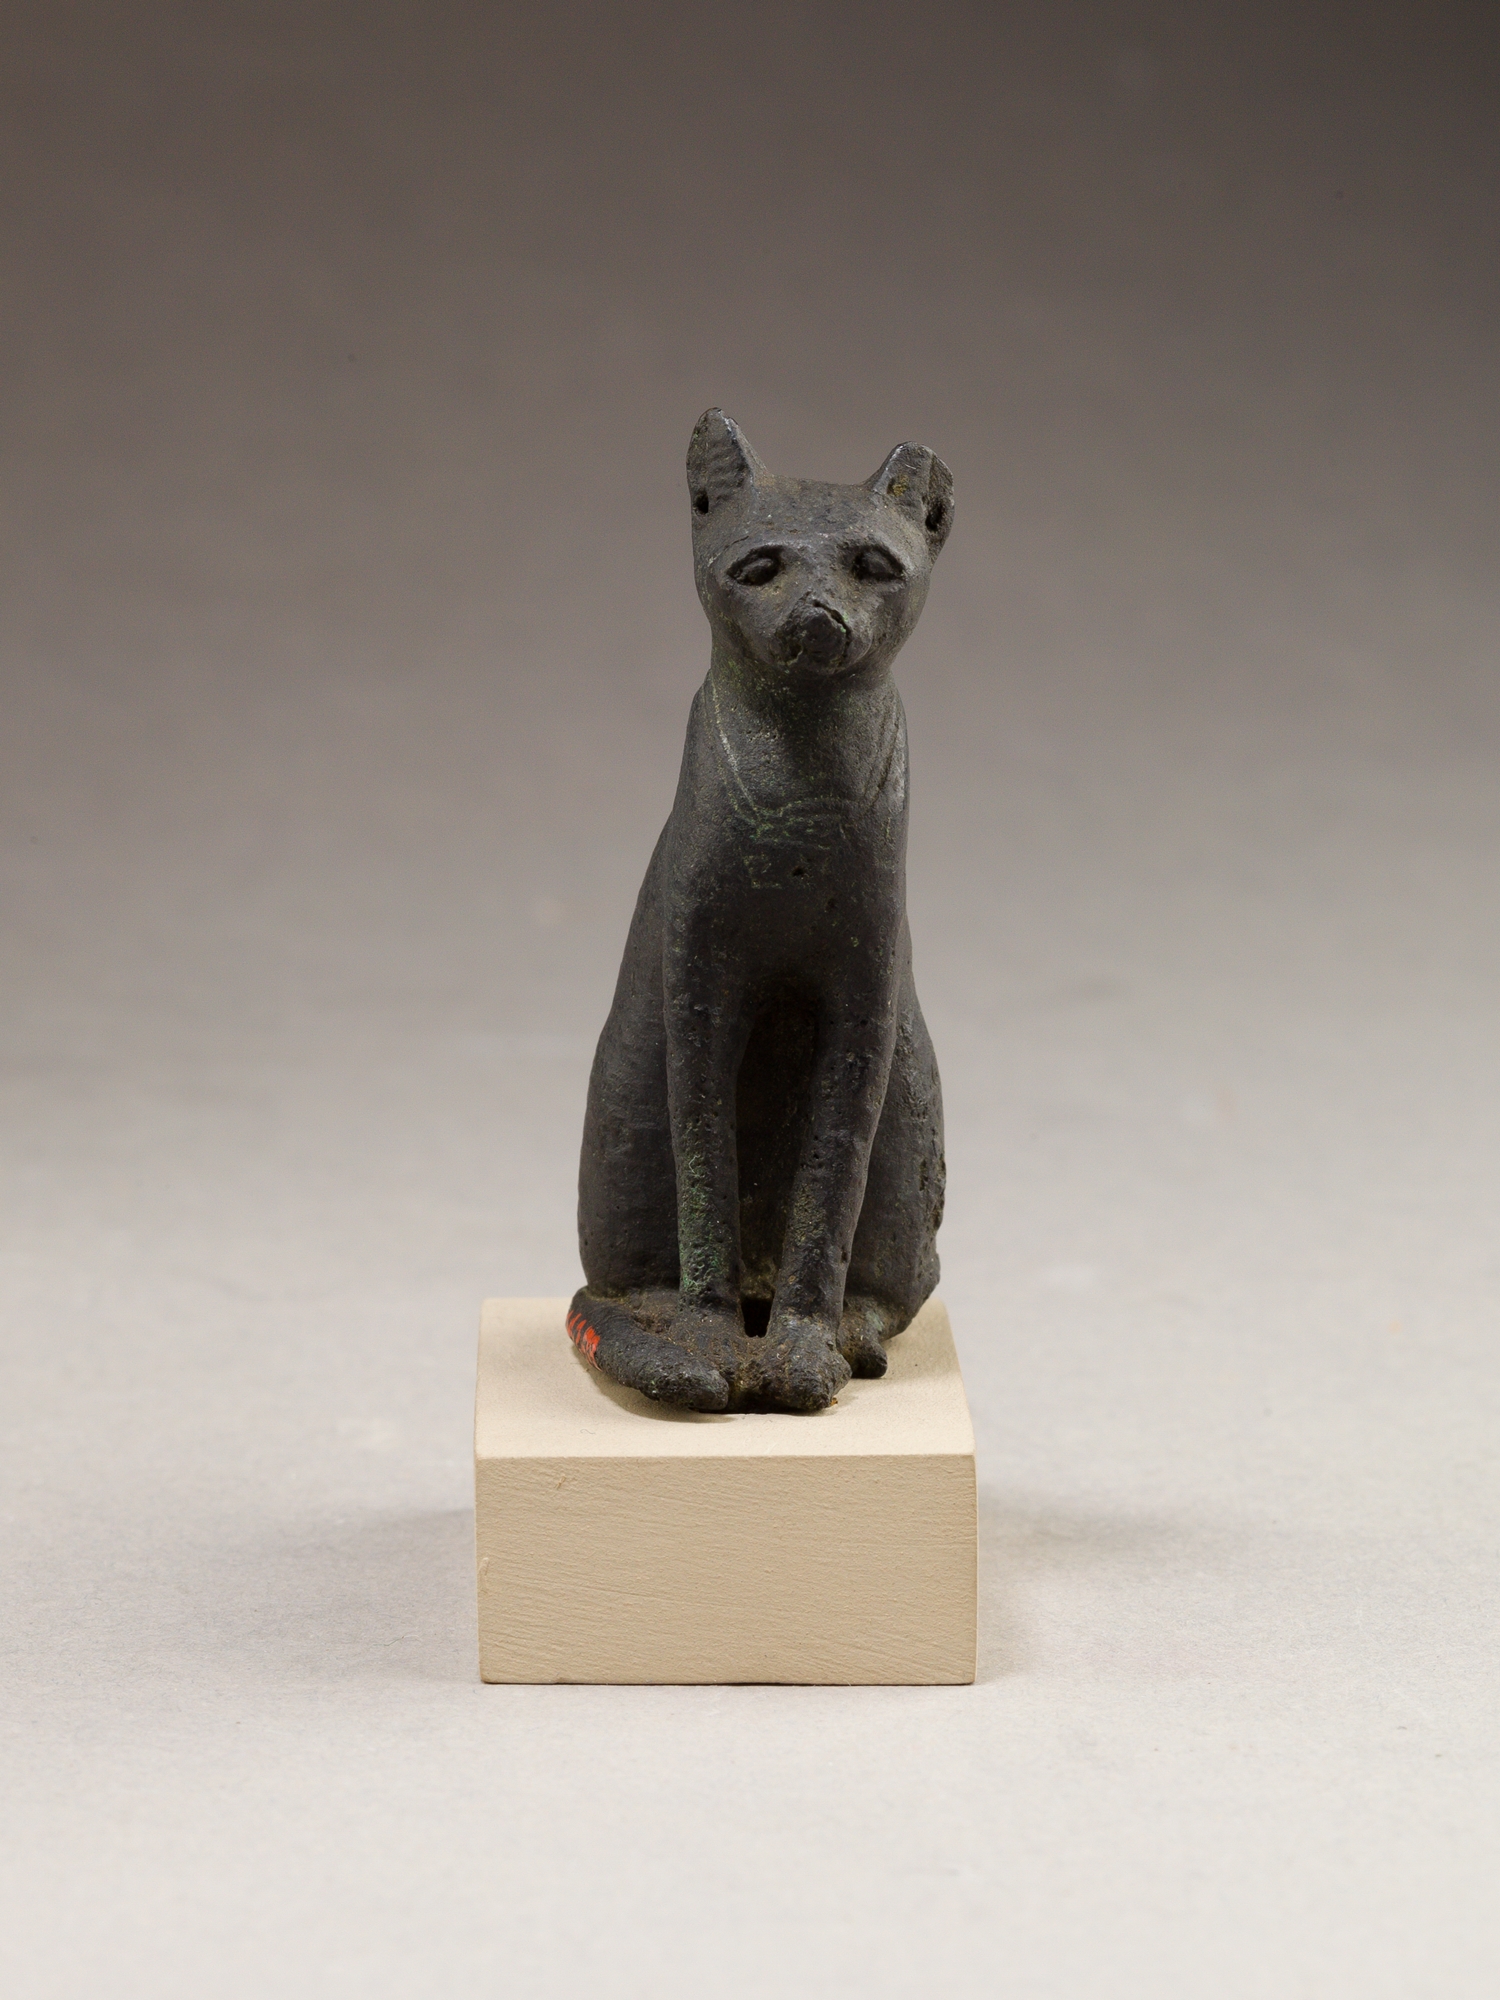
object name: figurine, cat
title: Cat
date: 664-630 BCE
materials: metal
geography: egypt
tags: cats